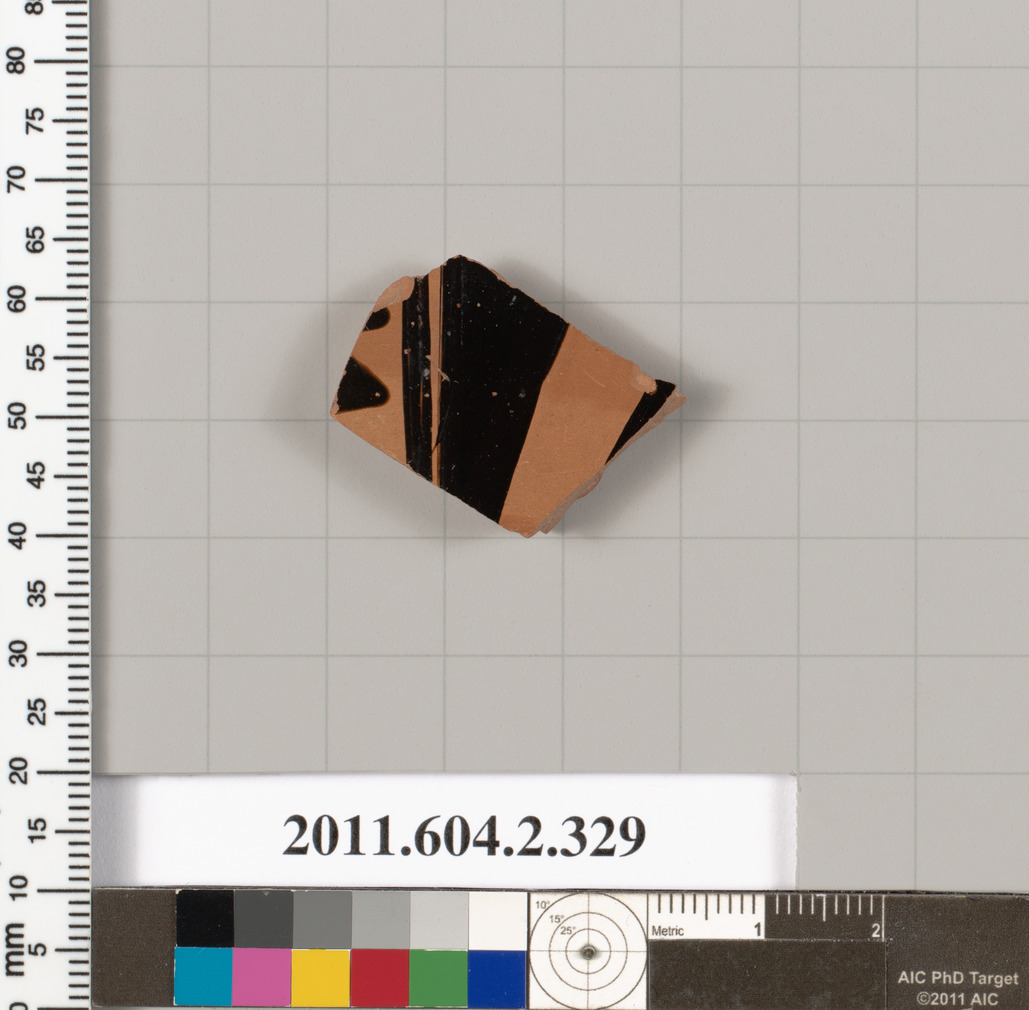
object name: column krater fragment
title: Terracotta fragment of a column-krater (bowl for mixing wine and water)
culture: greek, attic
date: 460-440 BCE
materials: terracotta